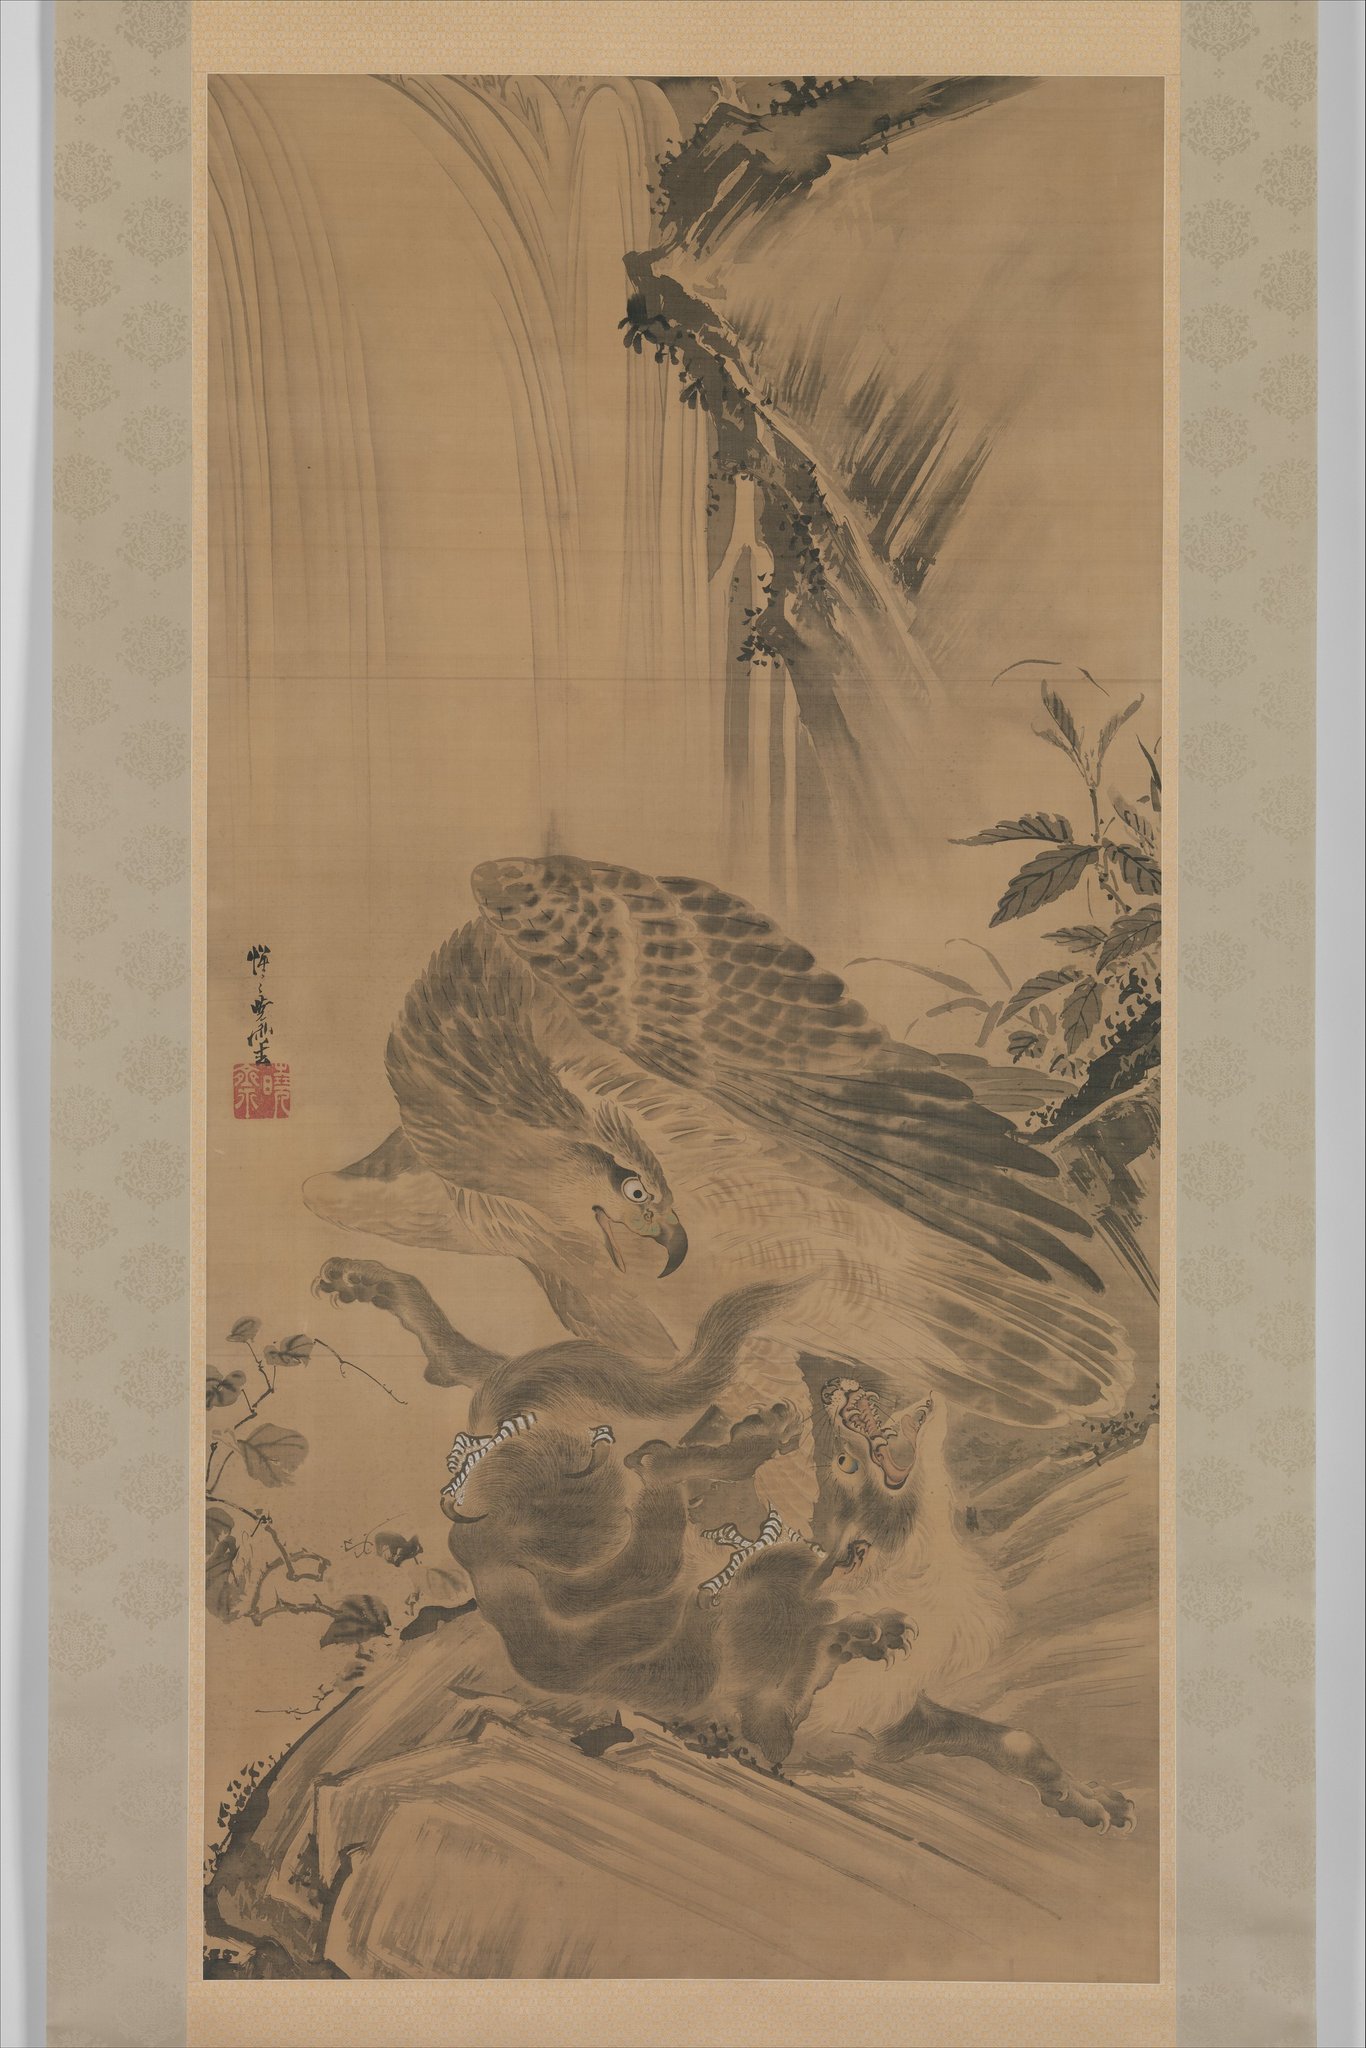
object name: hanging scroll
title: Eagle Attacking a Mountain Lion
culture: japanese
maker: kawanabe kyōsai 河鍋暁斎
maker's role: artist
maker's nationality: japanese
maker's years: 1831-1889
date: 1885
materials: ink, paper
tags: animals,eagles